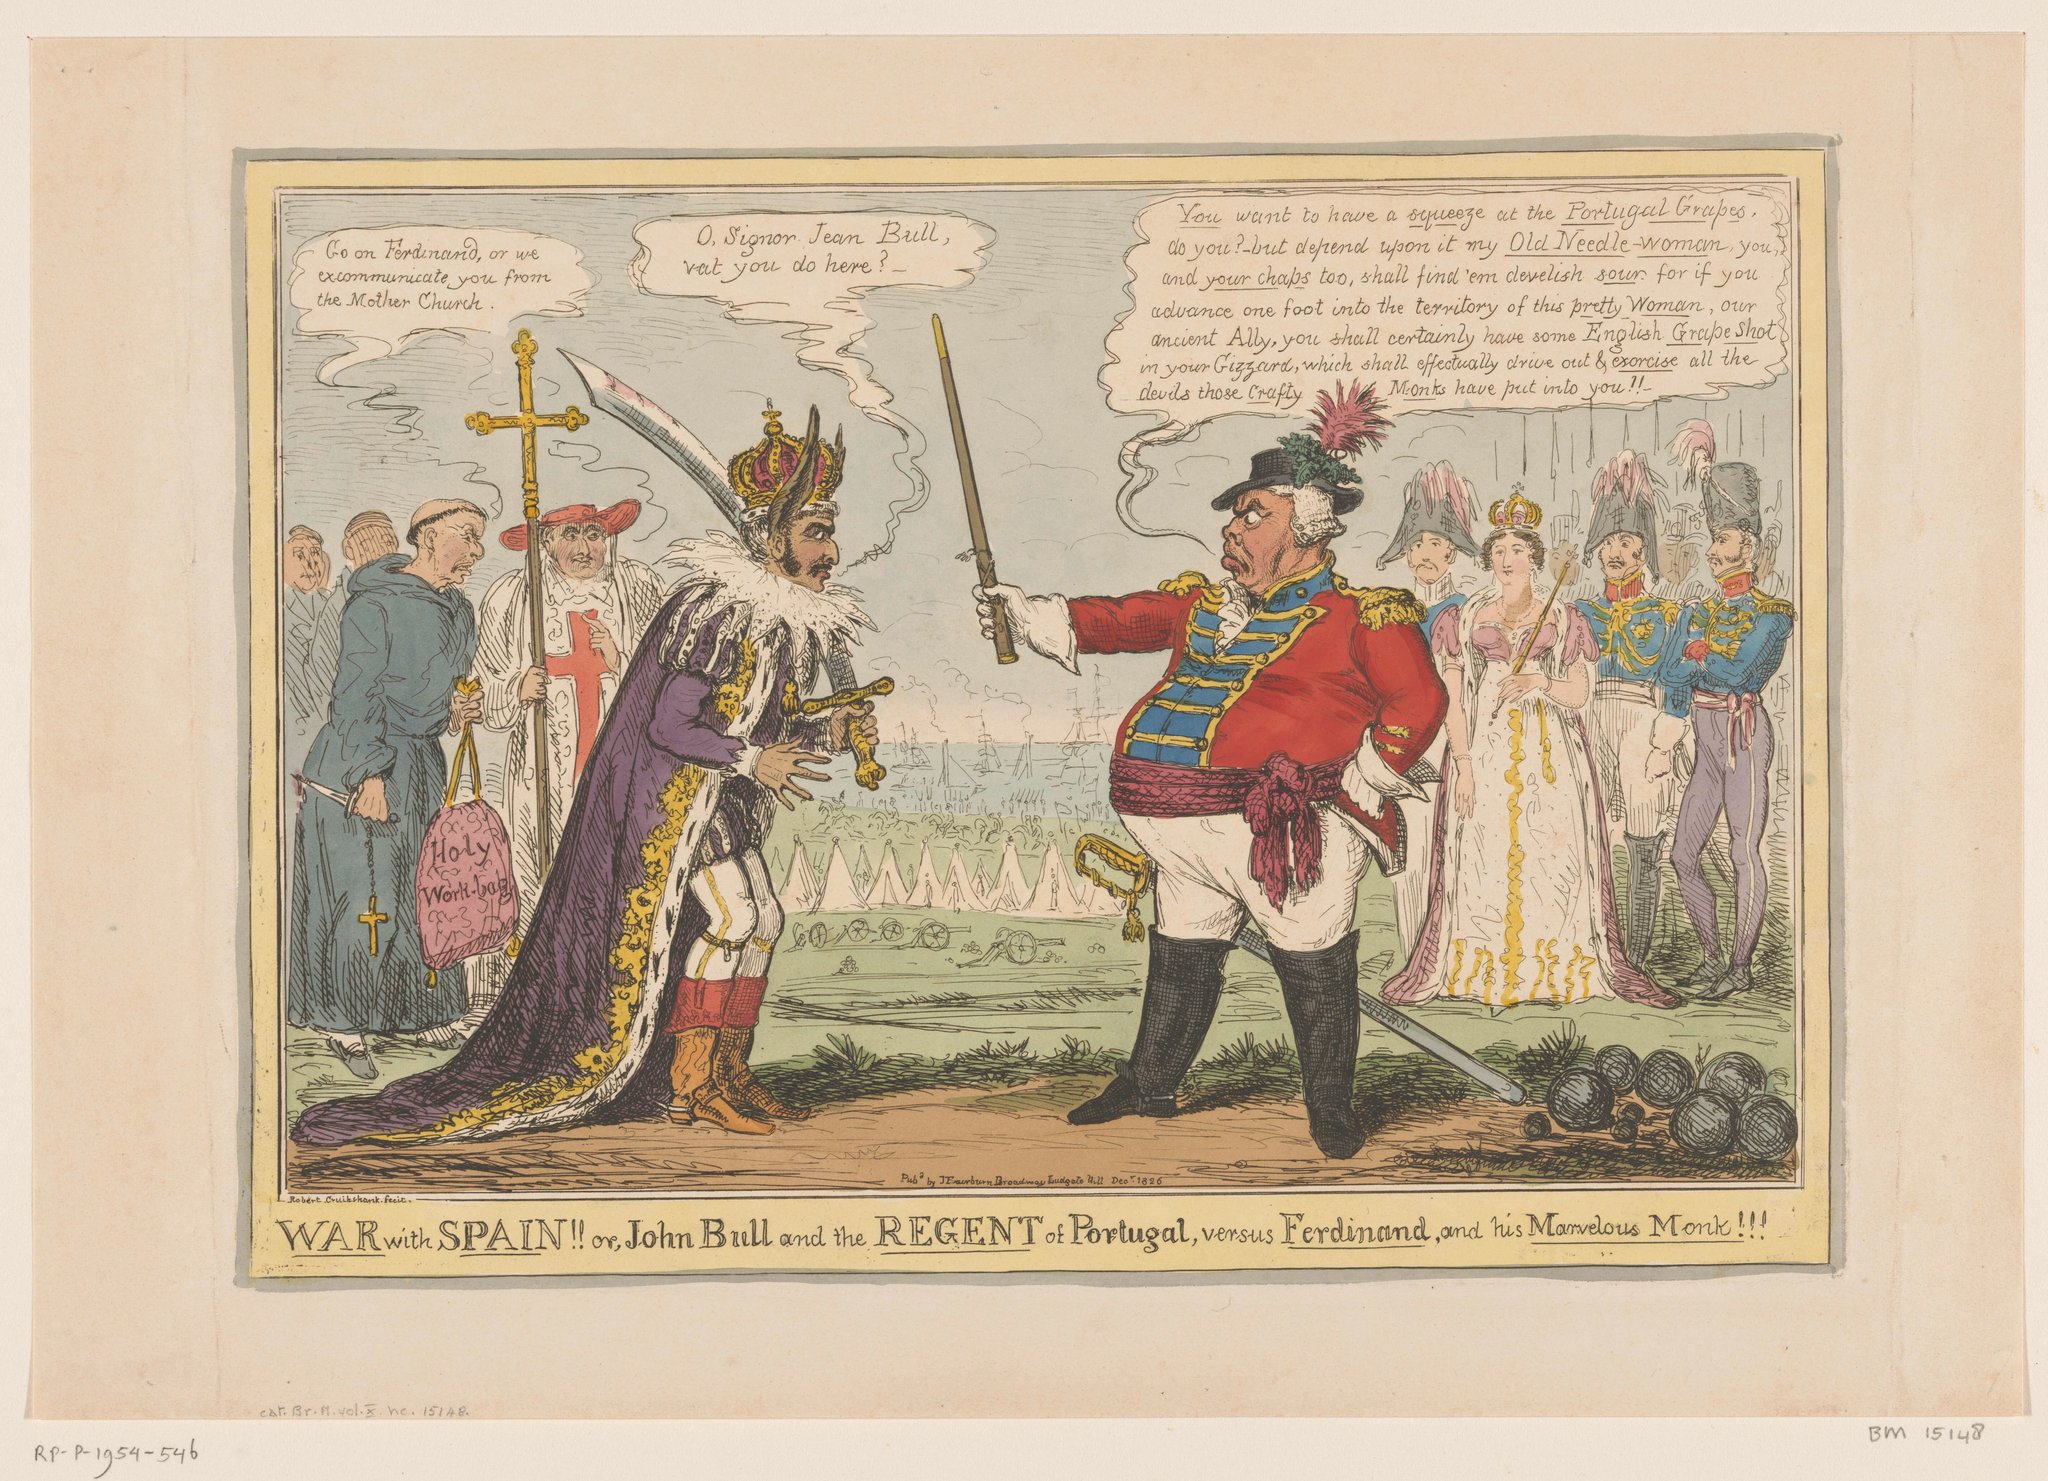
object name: cartoon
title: War with Spain!! or John Bull and the regent of Portugal, versus Ferdinand, and his marvelous monk!!!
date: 1812-1826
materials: paper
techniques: etching, hand coloring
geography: london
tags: ferdinand vii (koning van spanje), personifications of countries, nations, states, districts, etc., political caricatures and satires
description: Spotprent waarin John Bull (Groot-Brittannië) Spaanse koning Ferdinand VII confronteert. Naar aanleiding van de Aankomst van een Britse leger in Portugal ter bescherming tegen aanvallen vanuit Spanje. Achter de koning staan een monnik en een kardinaal. Achter John Bull staat Isabella Maria, infante van Portugal met enkele militaire officieren.